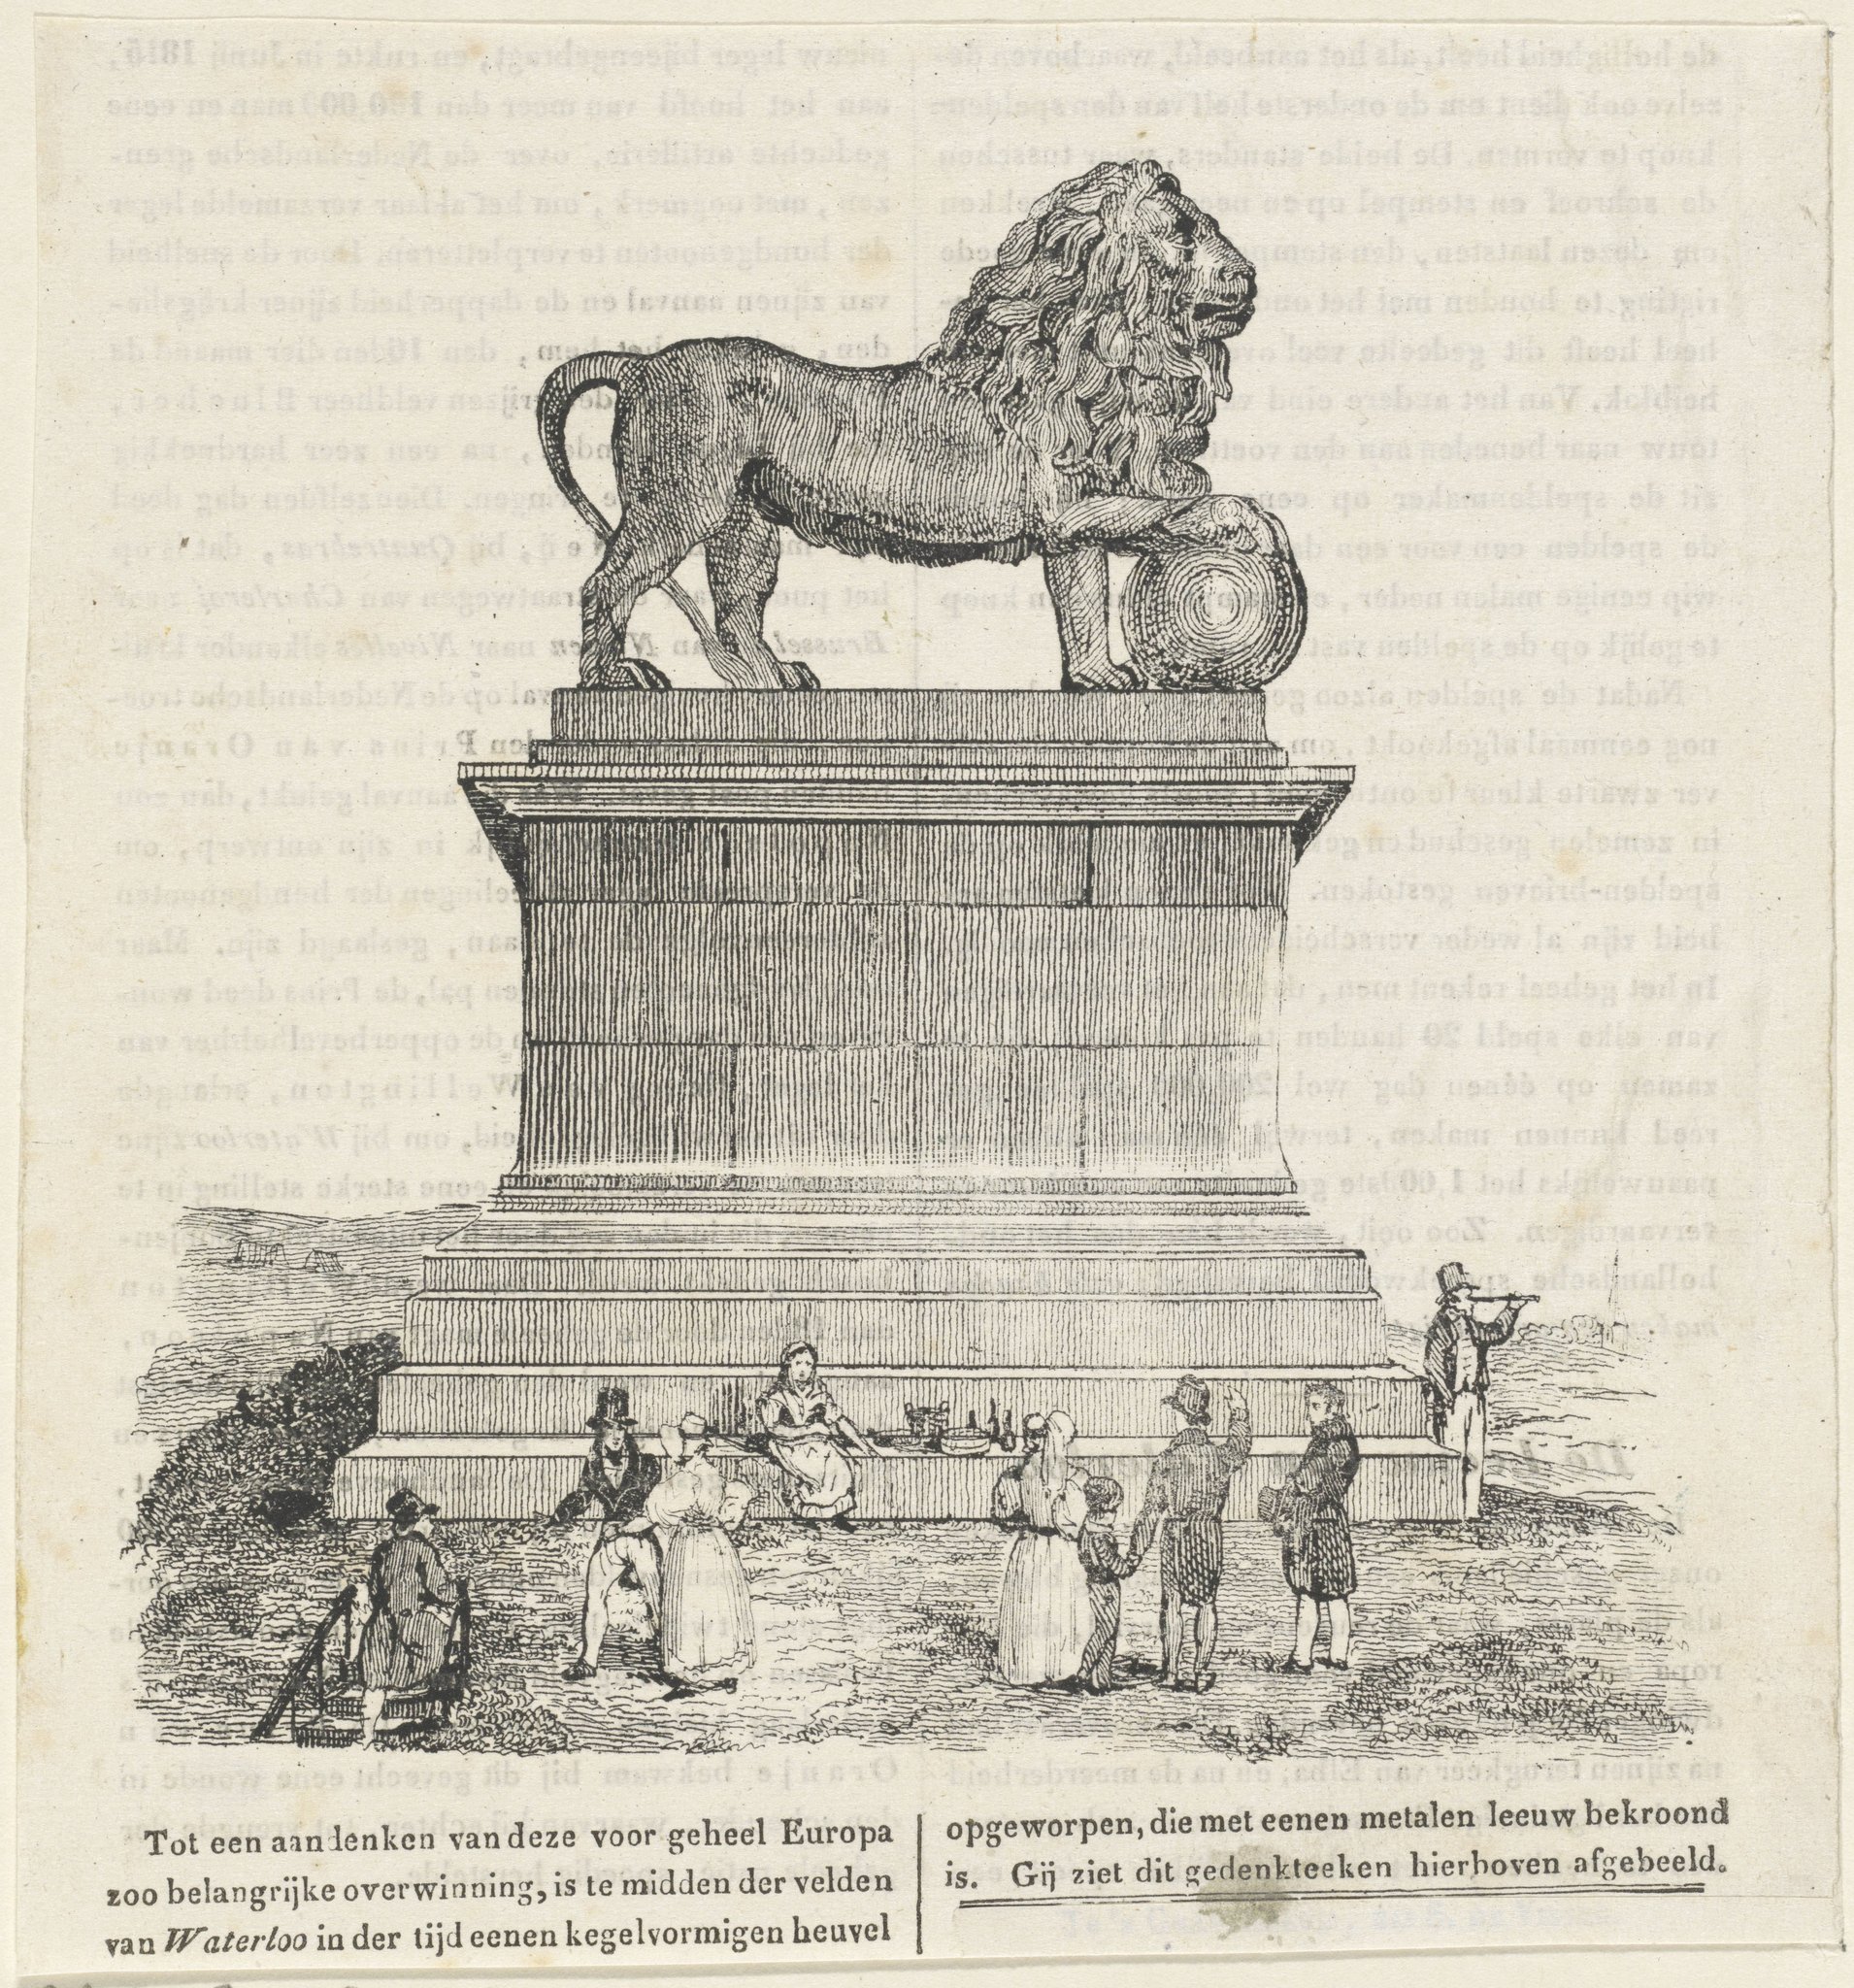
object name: book illustration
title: Monument voor de Slag bij Waterloo, 18 juni 1815, te Braine l' Alleu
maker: Anonymous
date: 1826-1899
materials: paper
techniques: letterpress printing, engraving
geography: netherlands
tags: piece of sculpture, reproduction of a piece of sculpture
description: Monument voor de Slag bij Waterloo, 18 juni 1815, te Braine l' Alleu. Beeld van een leeuw op een voetstuk. Er omheen staat een aantal figuren.